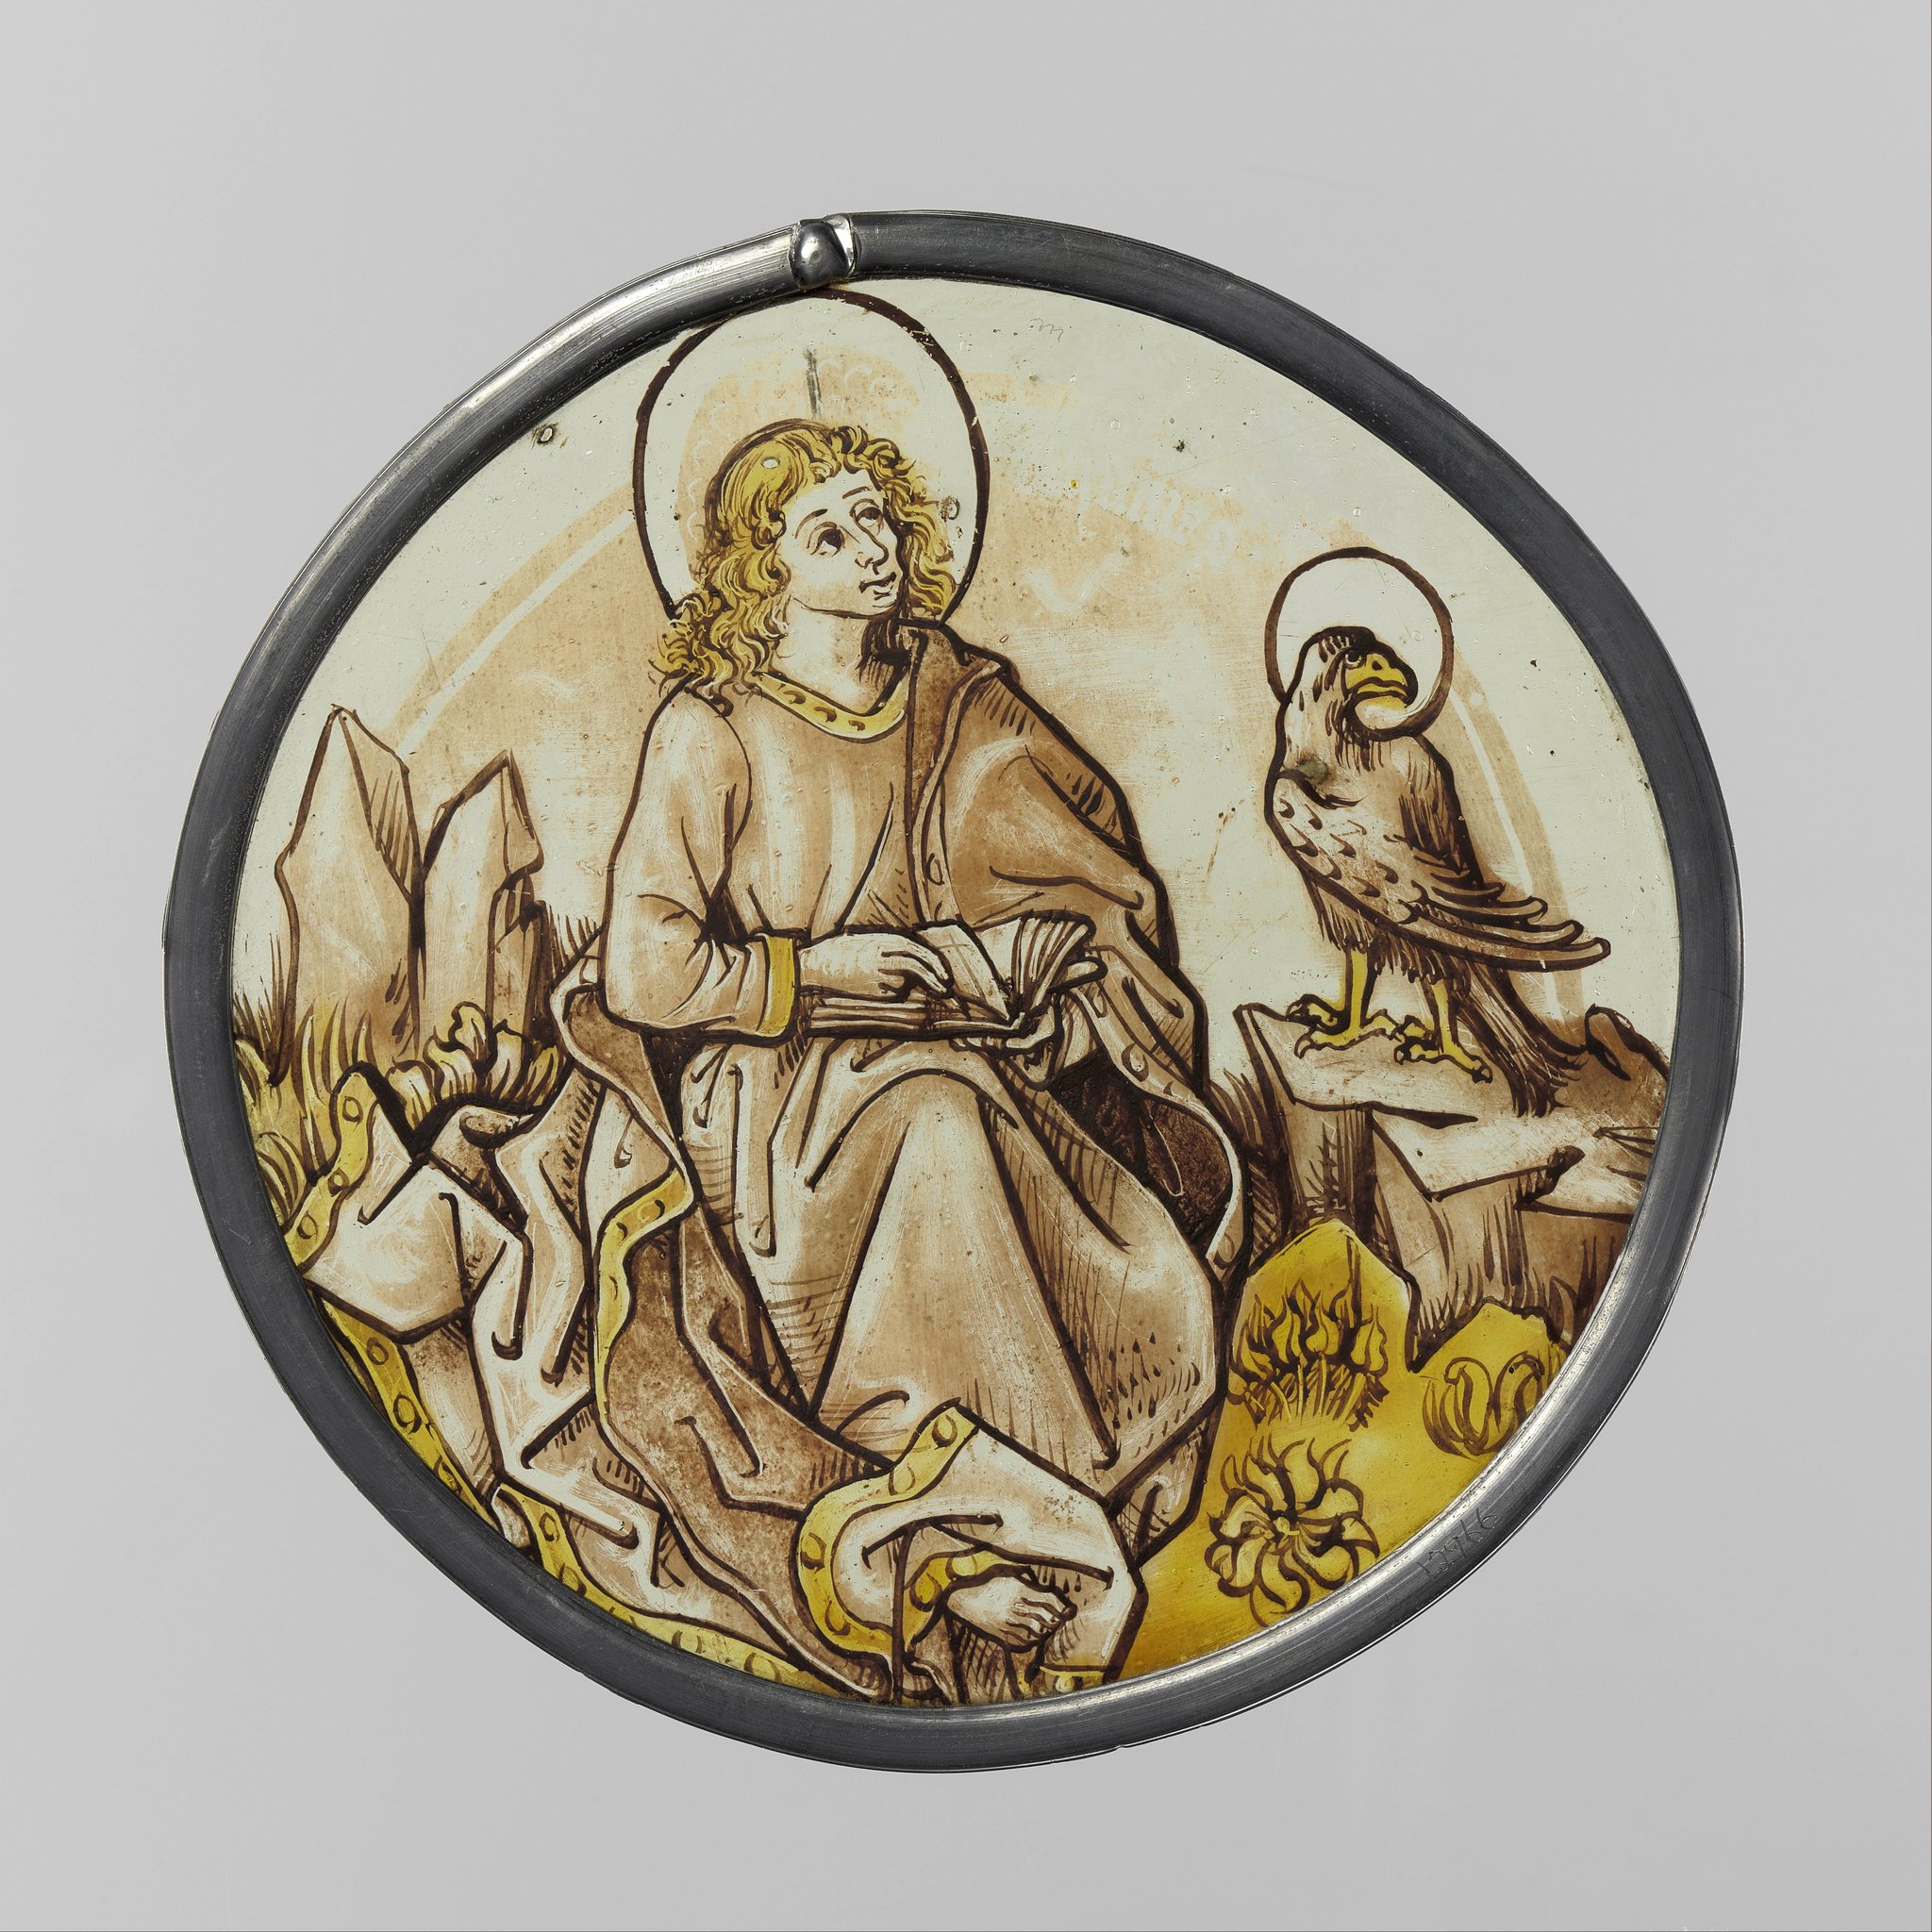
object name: light window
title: Ruit met de evangelist Johannes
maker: meester e.s.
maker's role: print maker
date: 1460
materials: glass, lead, pigment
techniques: leading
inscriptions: inscription: ‘JOHANIES’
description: St John the Evangelist. Stained glass. Germany (?), c. 1450 - 1475.